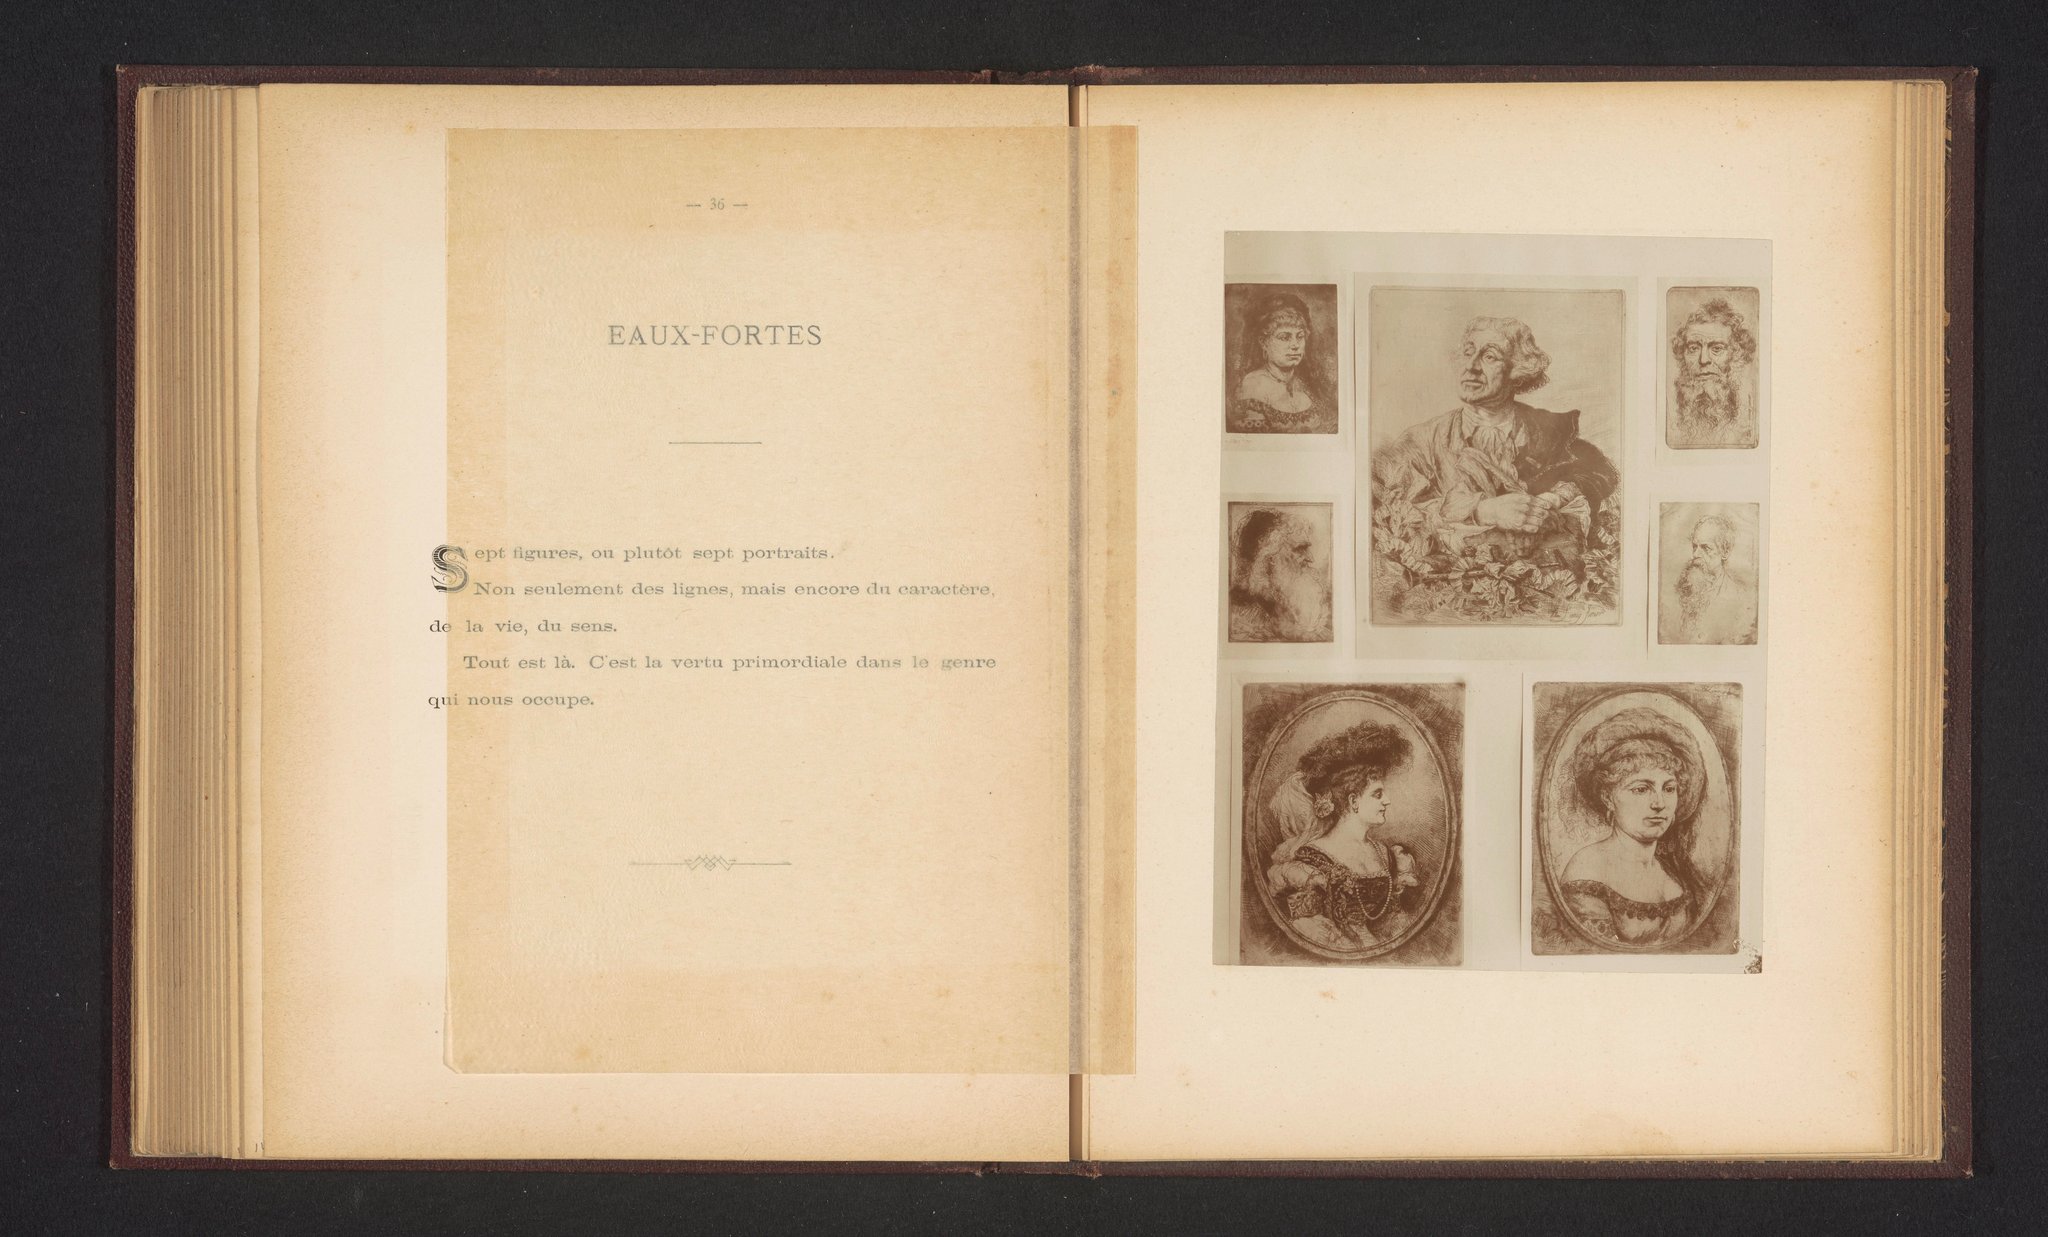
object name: reproduction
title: Fotoreproductie van zeven etsen van portretten van onbekende mensen door Willem Linnig (II)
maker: alexandre van antro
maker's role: painter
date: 1891-1896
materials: photographic support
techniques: collodion silver print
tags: historical persons not known by name - bb - woman, historical persons not known by name